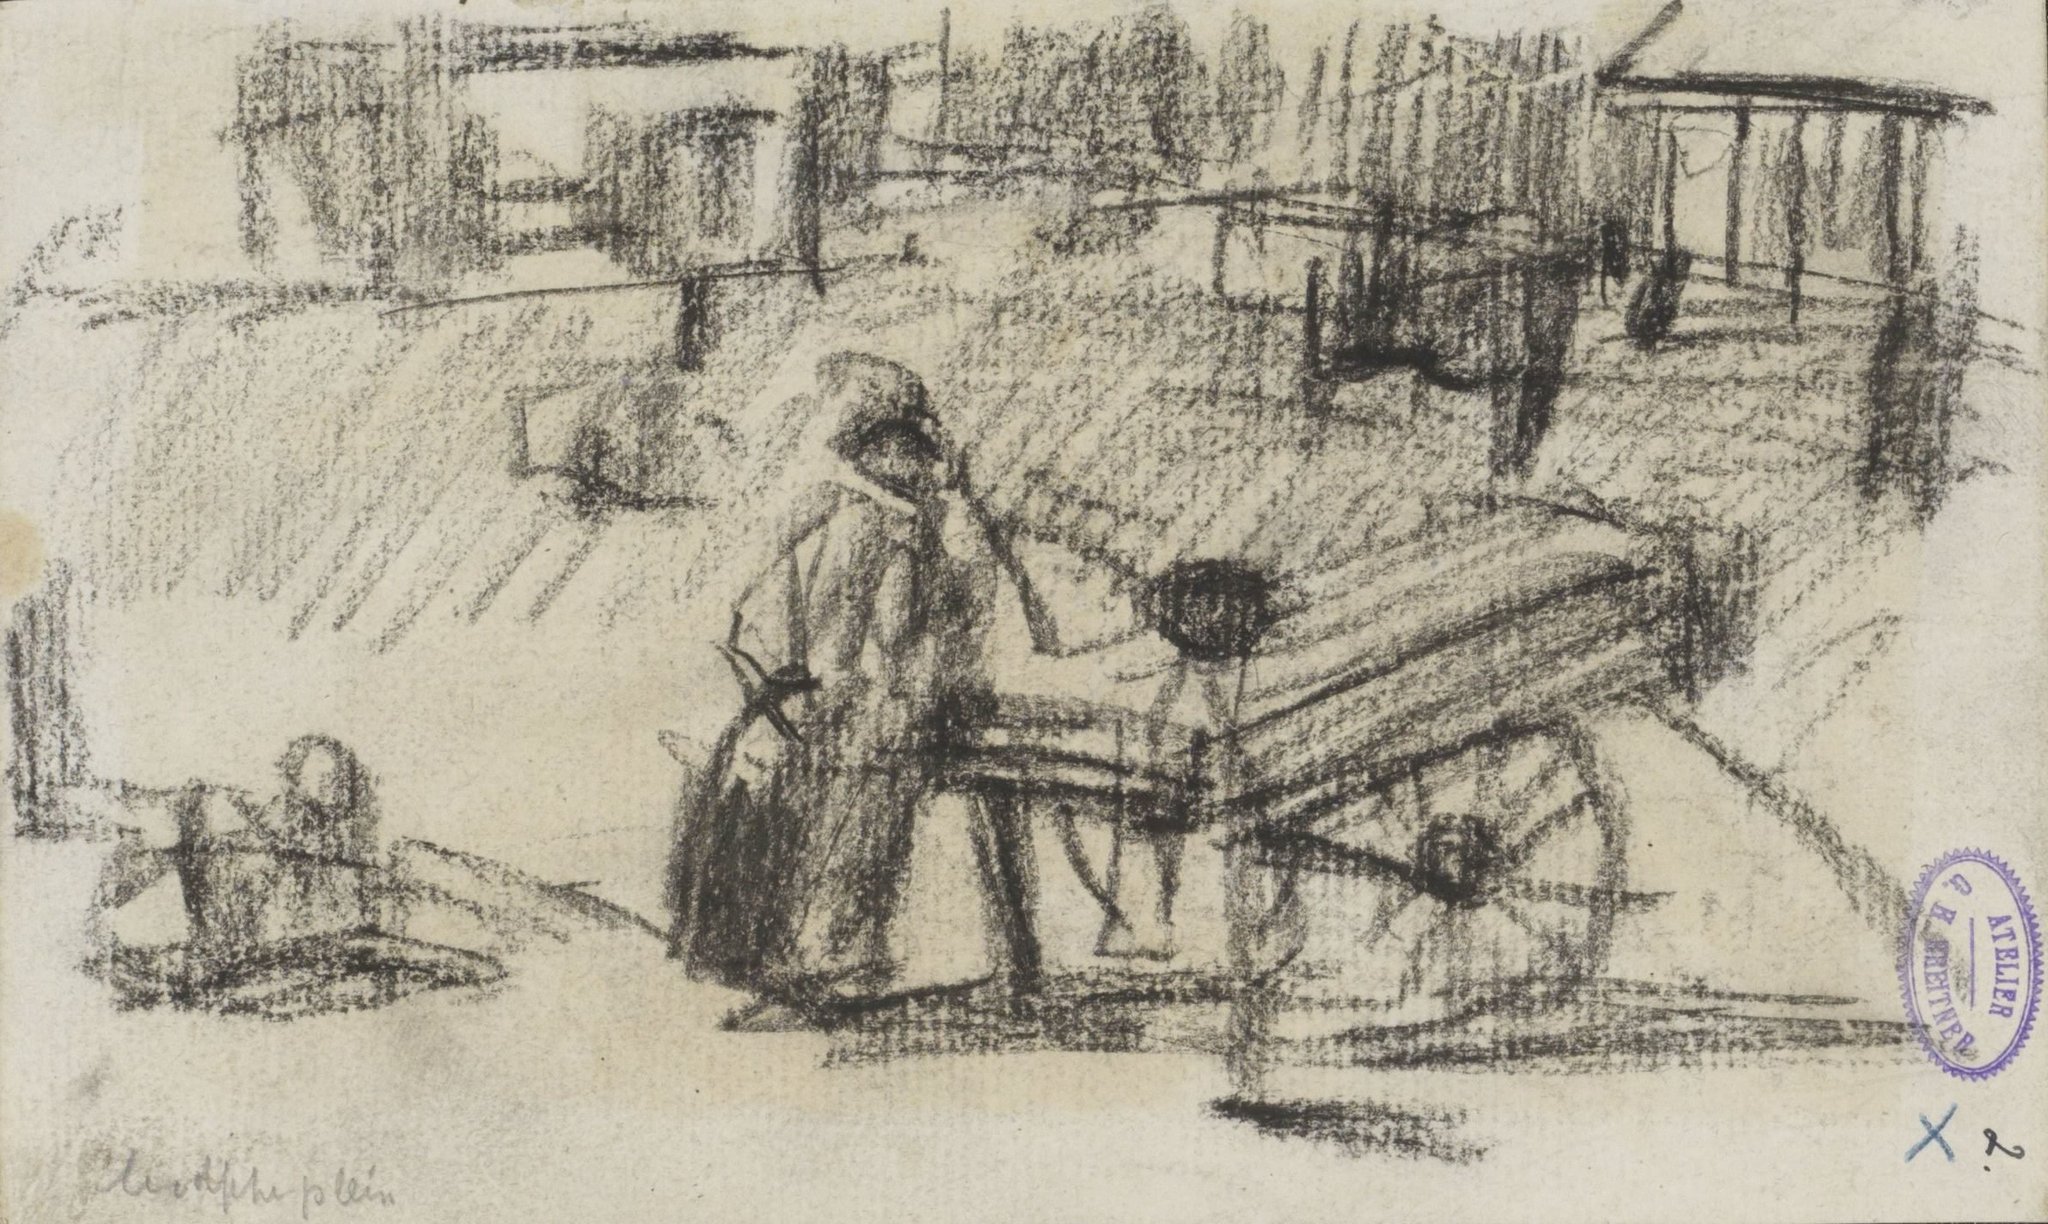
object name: drawing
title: Handkar op het Leidseplein te Amsterdam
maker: george hendrik breitner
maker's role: draughtsman, painter, print maker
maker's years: 1857-1923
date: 1882-1903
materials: chalk, paper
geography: amsterdam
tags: hand-cart, square, place, circus, etc. (+ city(-scape) with figures, staffage)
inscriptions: workshop stamp: Lugt 291d, annotation: ‘Leidsche plein’, collector's mark: Lugt 2228